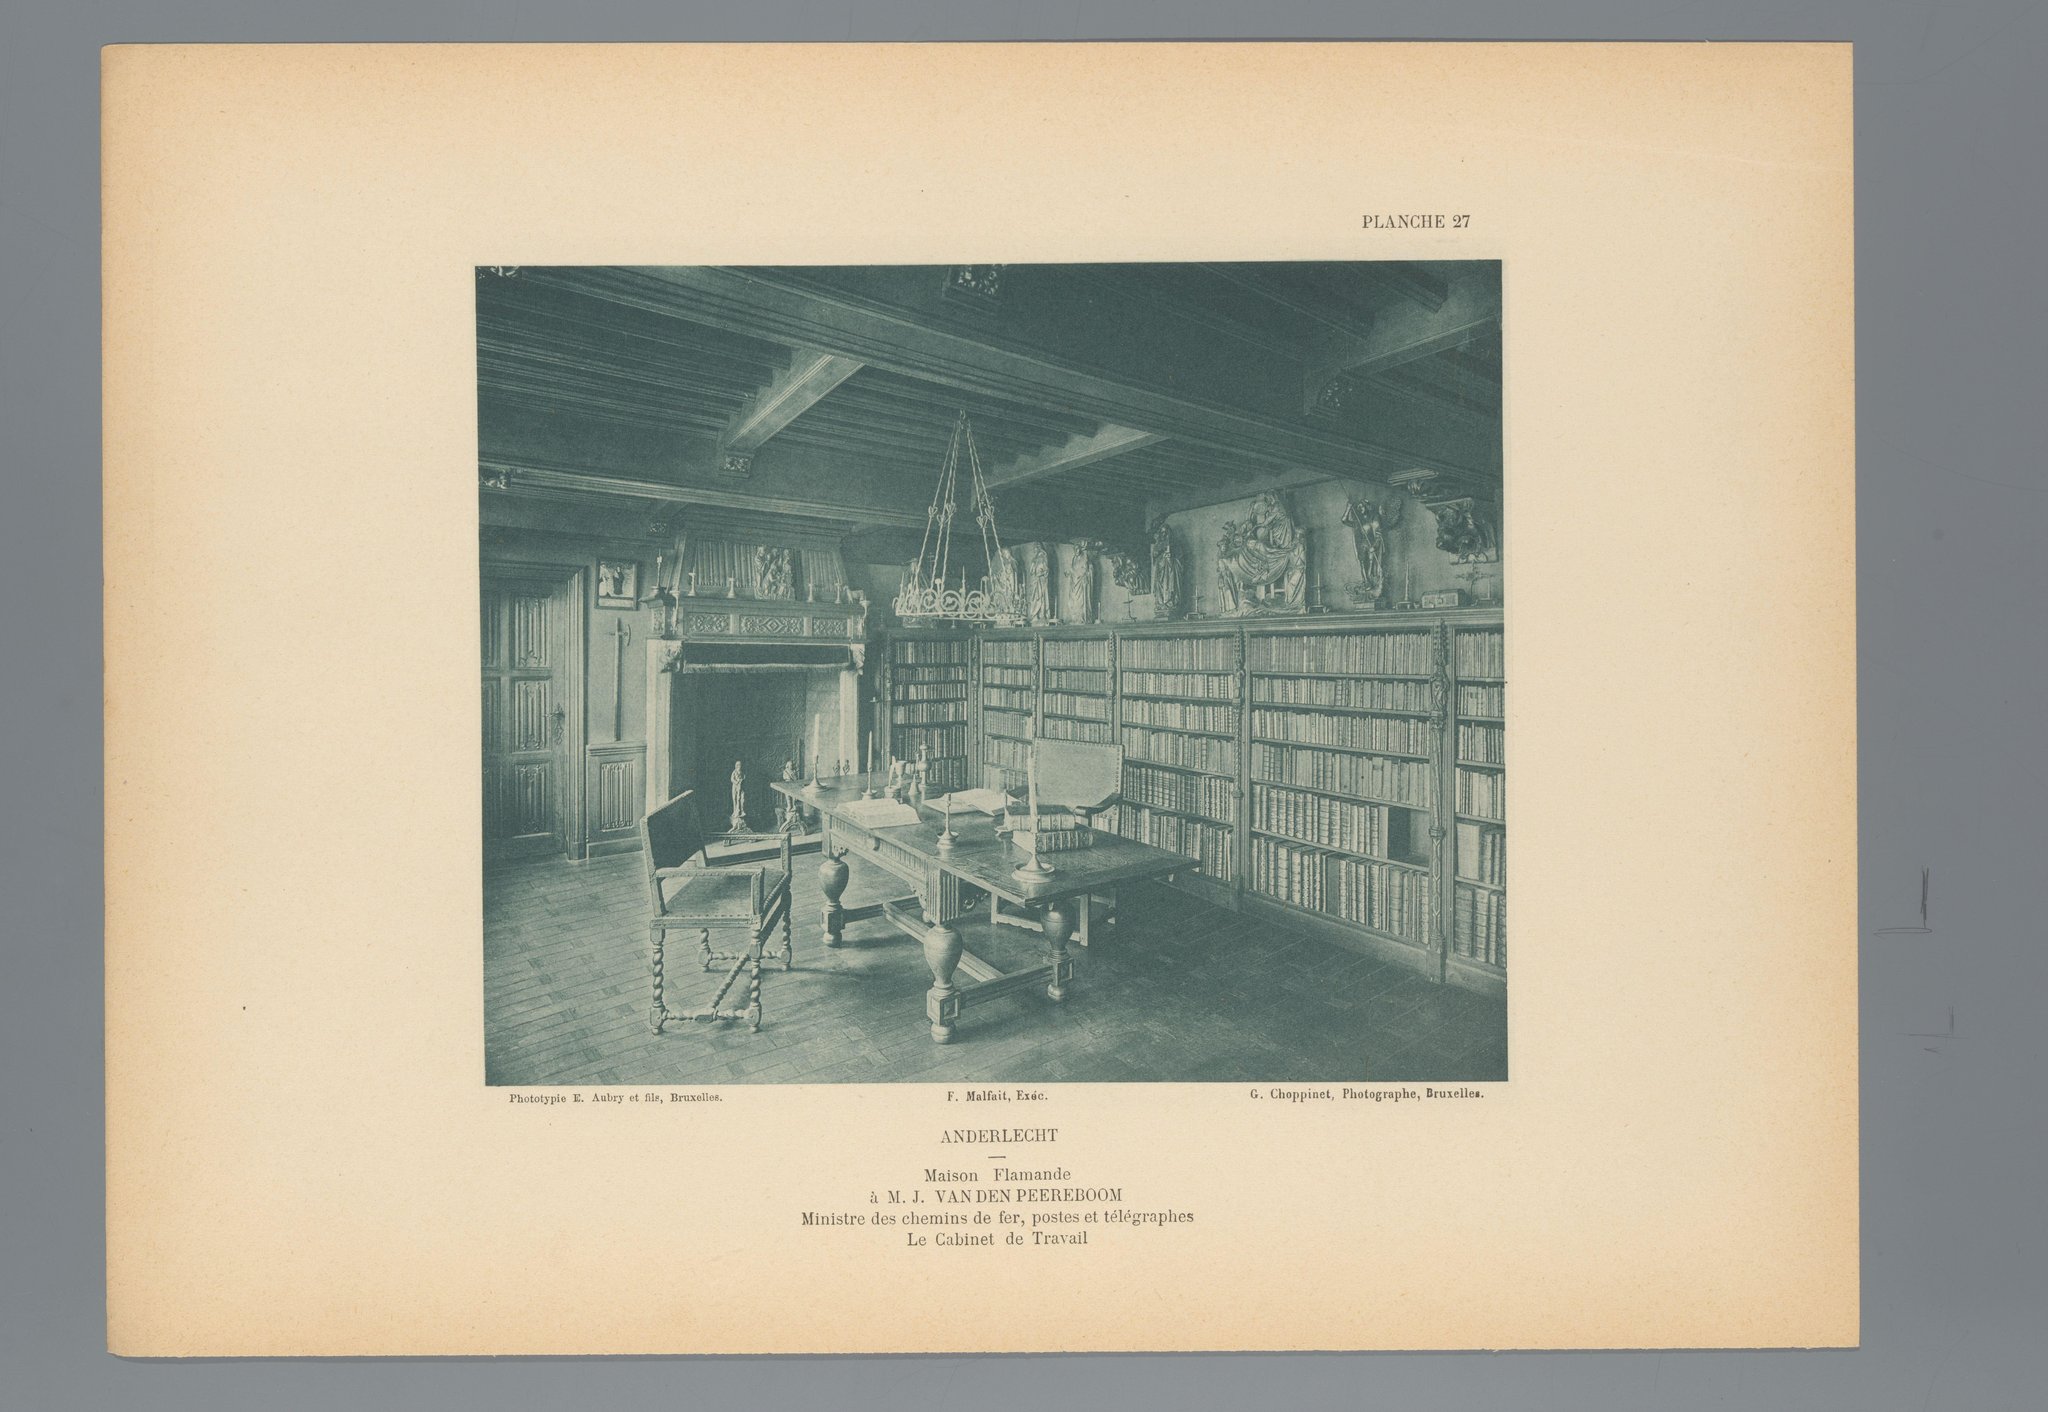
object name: photomechanical print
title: Anderlecht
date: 1893-1898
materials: paper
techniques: photograph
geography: brussels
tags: study; 'studiolo'; library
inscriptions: inscription: ‘Maison Flamande/ à M. J. VANDEN PEEREBOOM/ Ministre des chemins de fer, postes et télégraphes/ Le Cabinet de Travail’, number: ‘PLANCHE 27’, name: ‘F. Malfait, Exéc.’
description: Deze prent maakt deel uit van een omslag met 89 prenten en 5 tekstbladen.